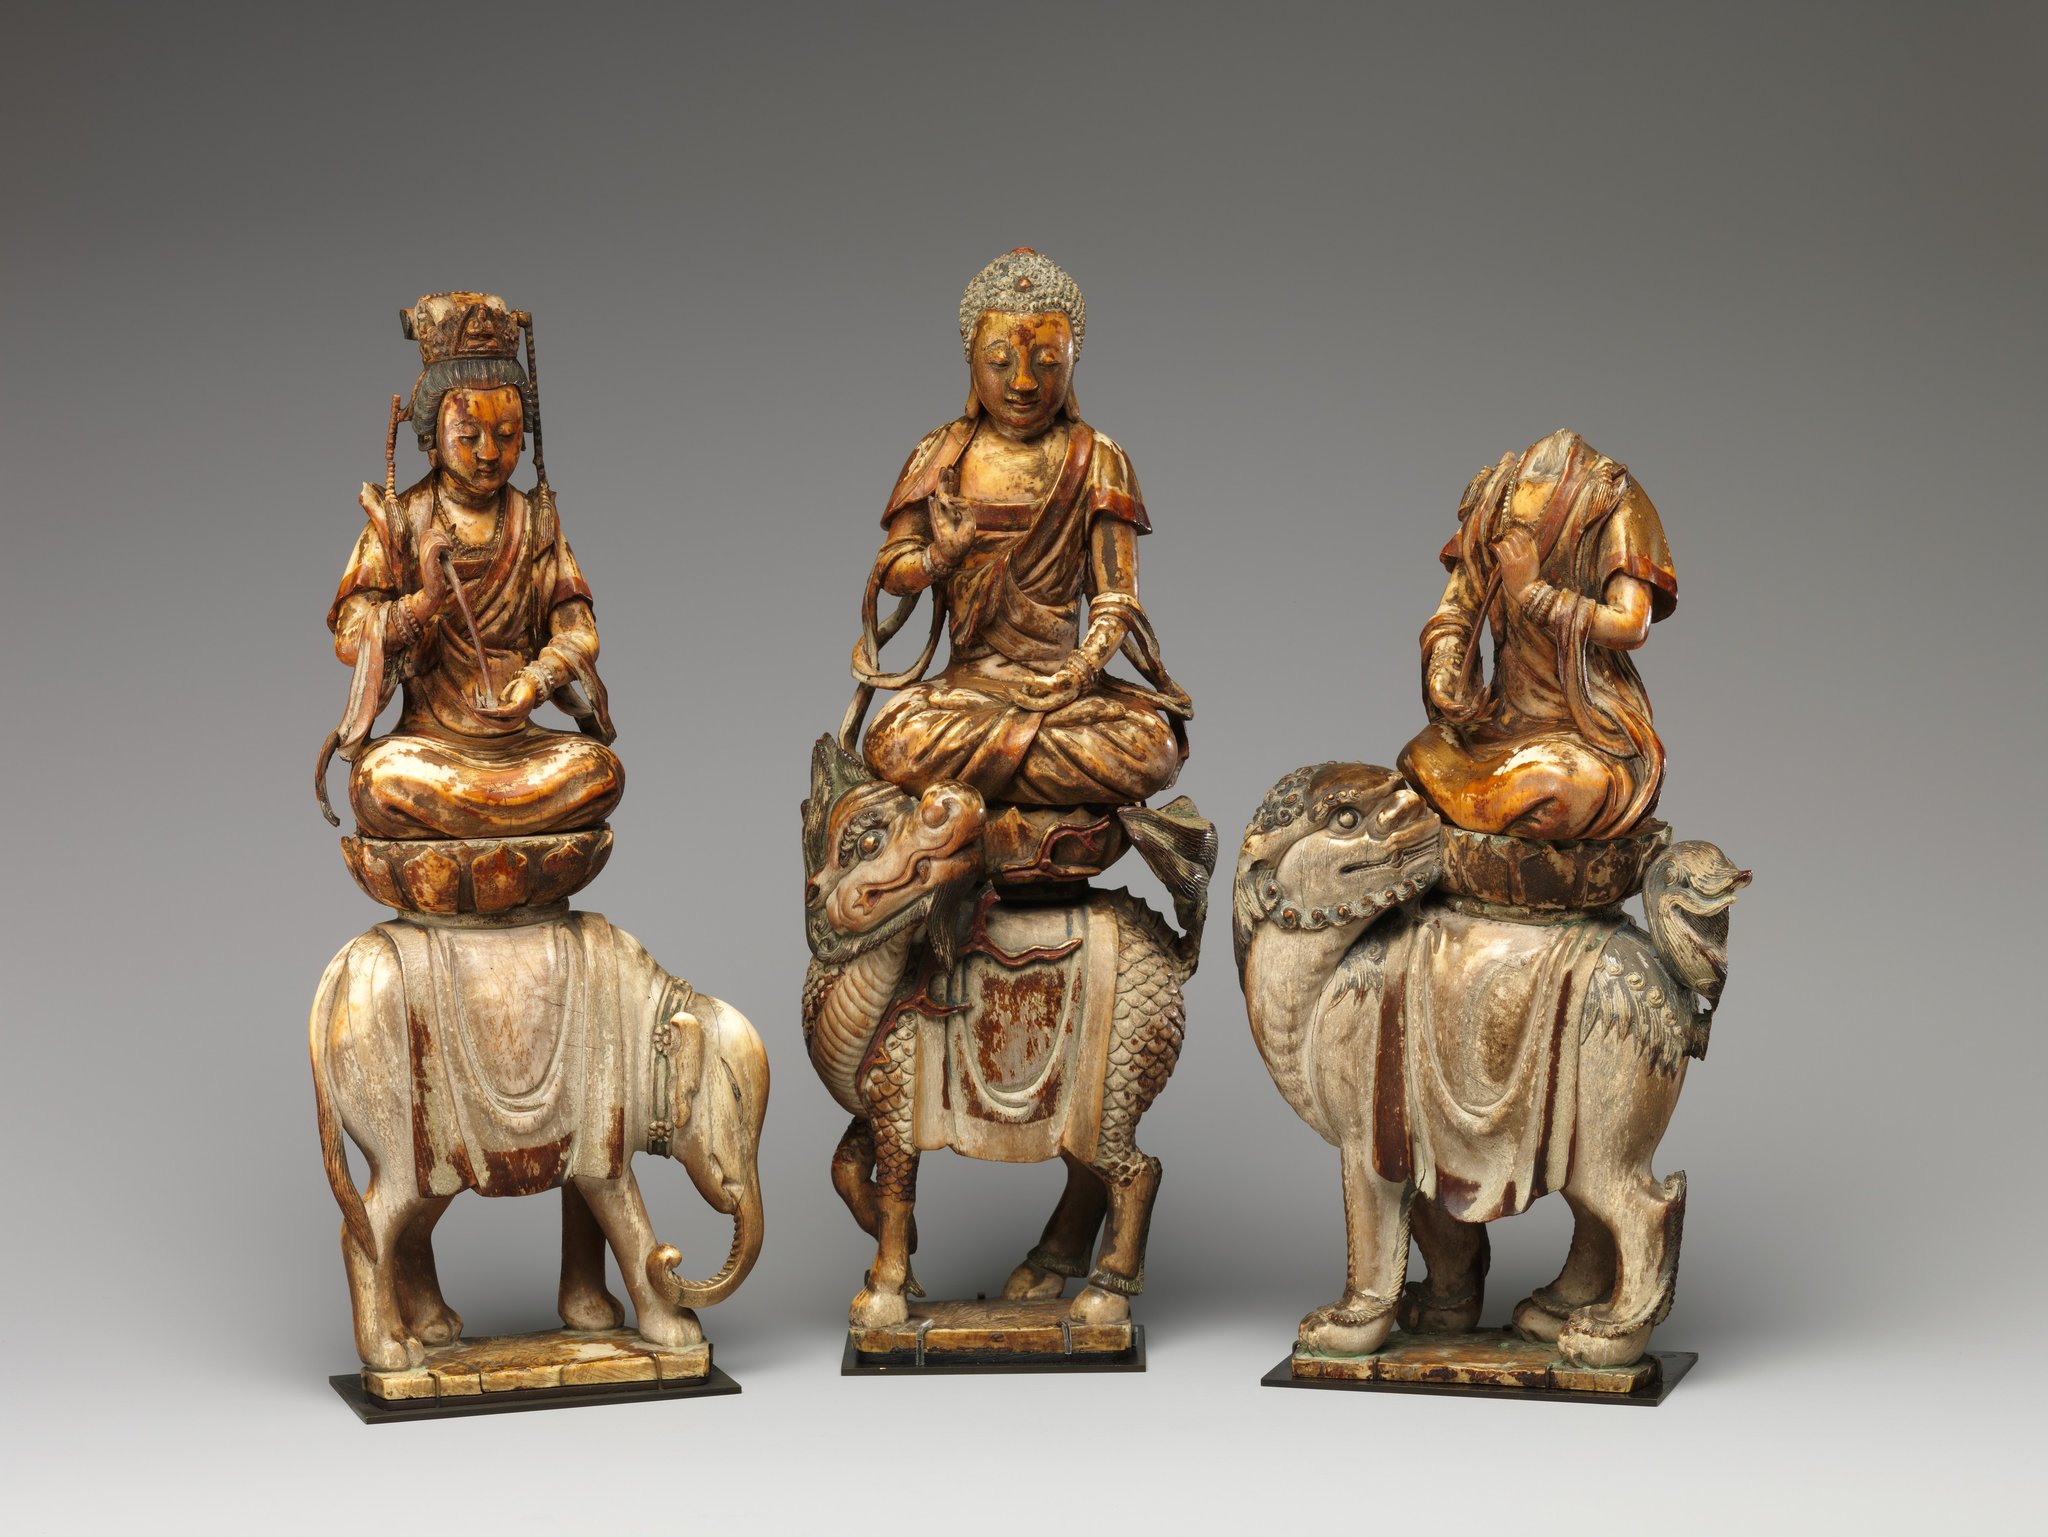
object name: figure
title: Buddha Shakyamuni with attendant bodhisattvas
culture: chinese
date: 1101-1400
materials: ivory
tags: mythical creatures,elephants,buddhism,bodhisattvas,shakyamuni